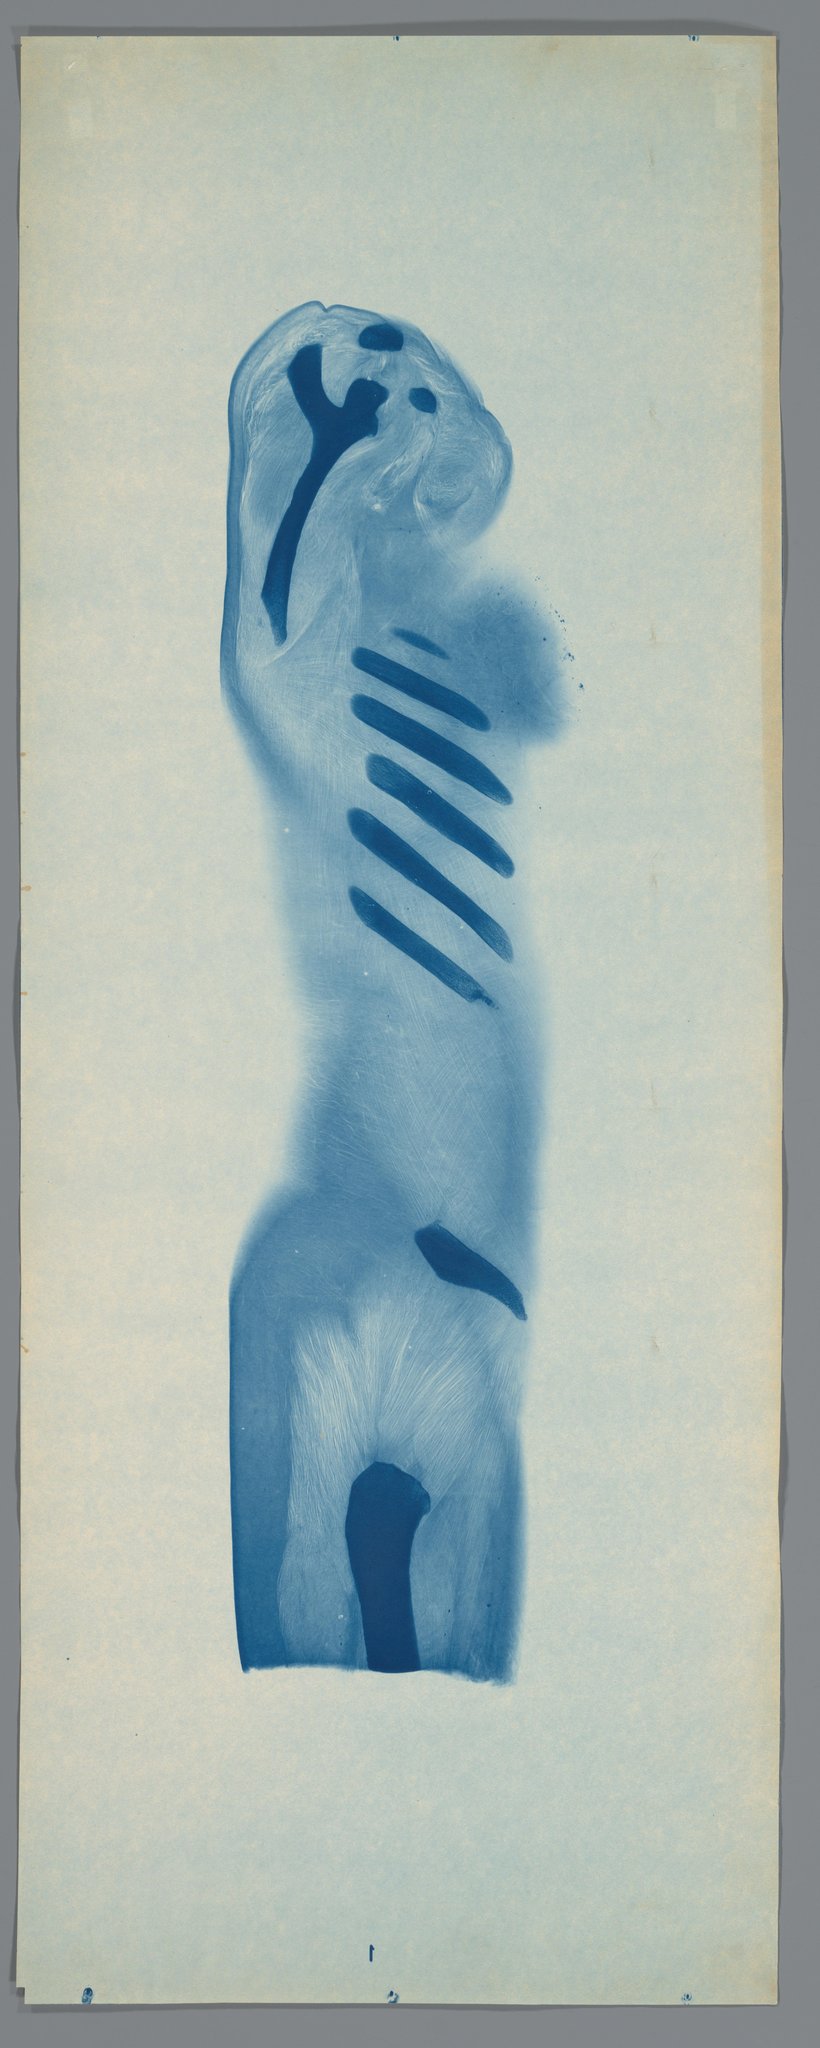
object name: photograph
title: Radiographic views of a sagittal sectioned human body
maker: harold o. mahoney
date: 1941-1949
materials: photographic support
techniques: cyanotype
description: Just how bizarre was the project of Mahoney, a radiologic technologist with the American company General Electric and a formally trained artist? In the 1930s, working with Northwestern University near Chicago, he created a technique allowing him to record soft tissue, in addition to bones, with X-rays. His team sectioned frozen bodies and made life-sized recordings of them. Only recently has it become clear that the (mostly African-American) cadavers, the ‘unclaimed bodies,’ came from the slums of Chicago.